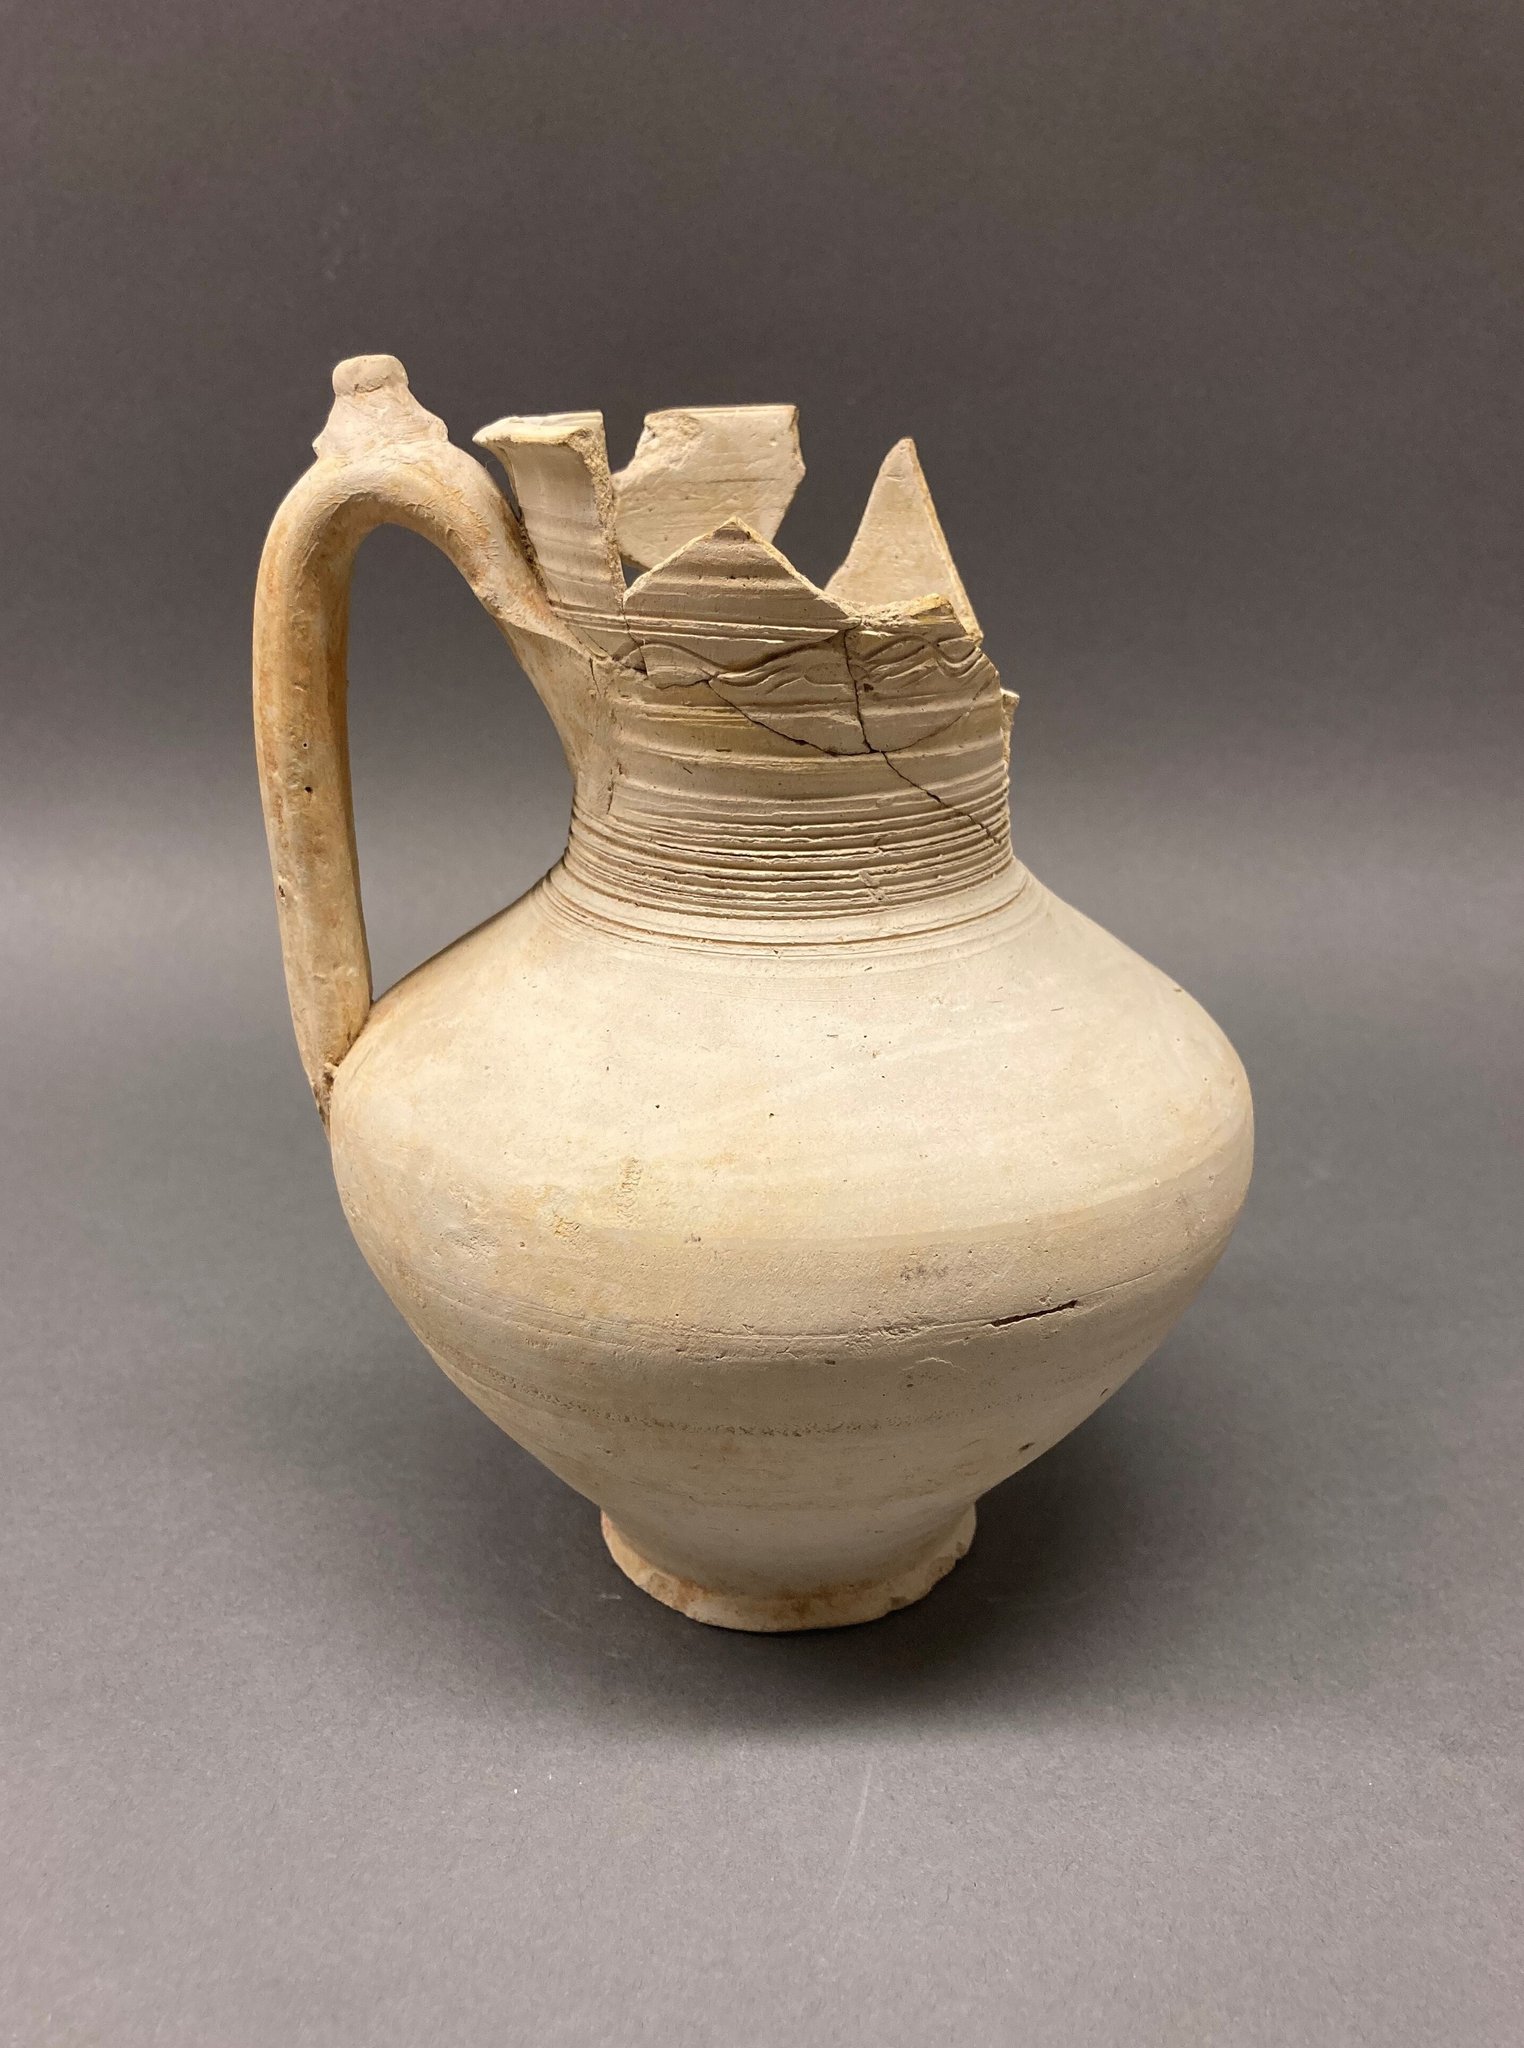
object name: ewer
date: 801-900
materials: earthenware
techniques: incising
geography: iran